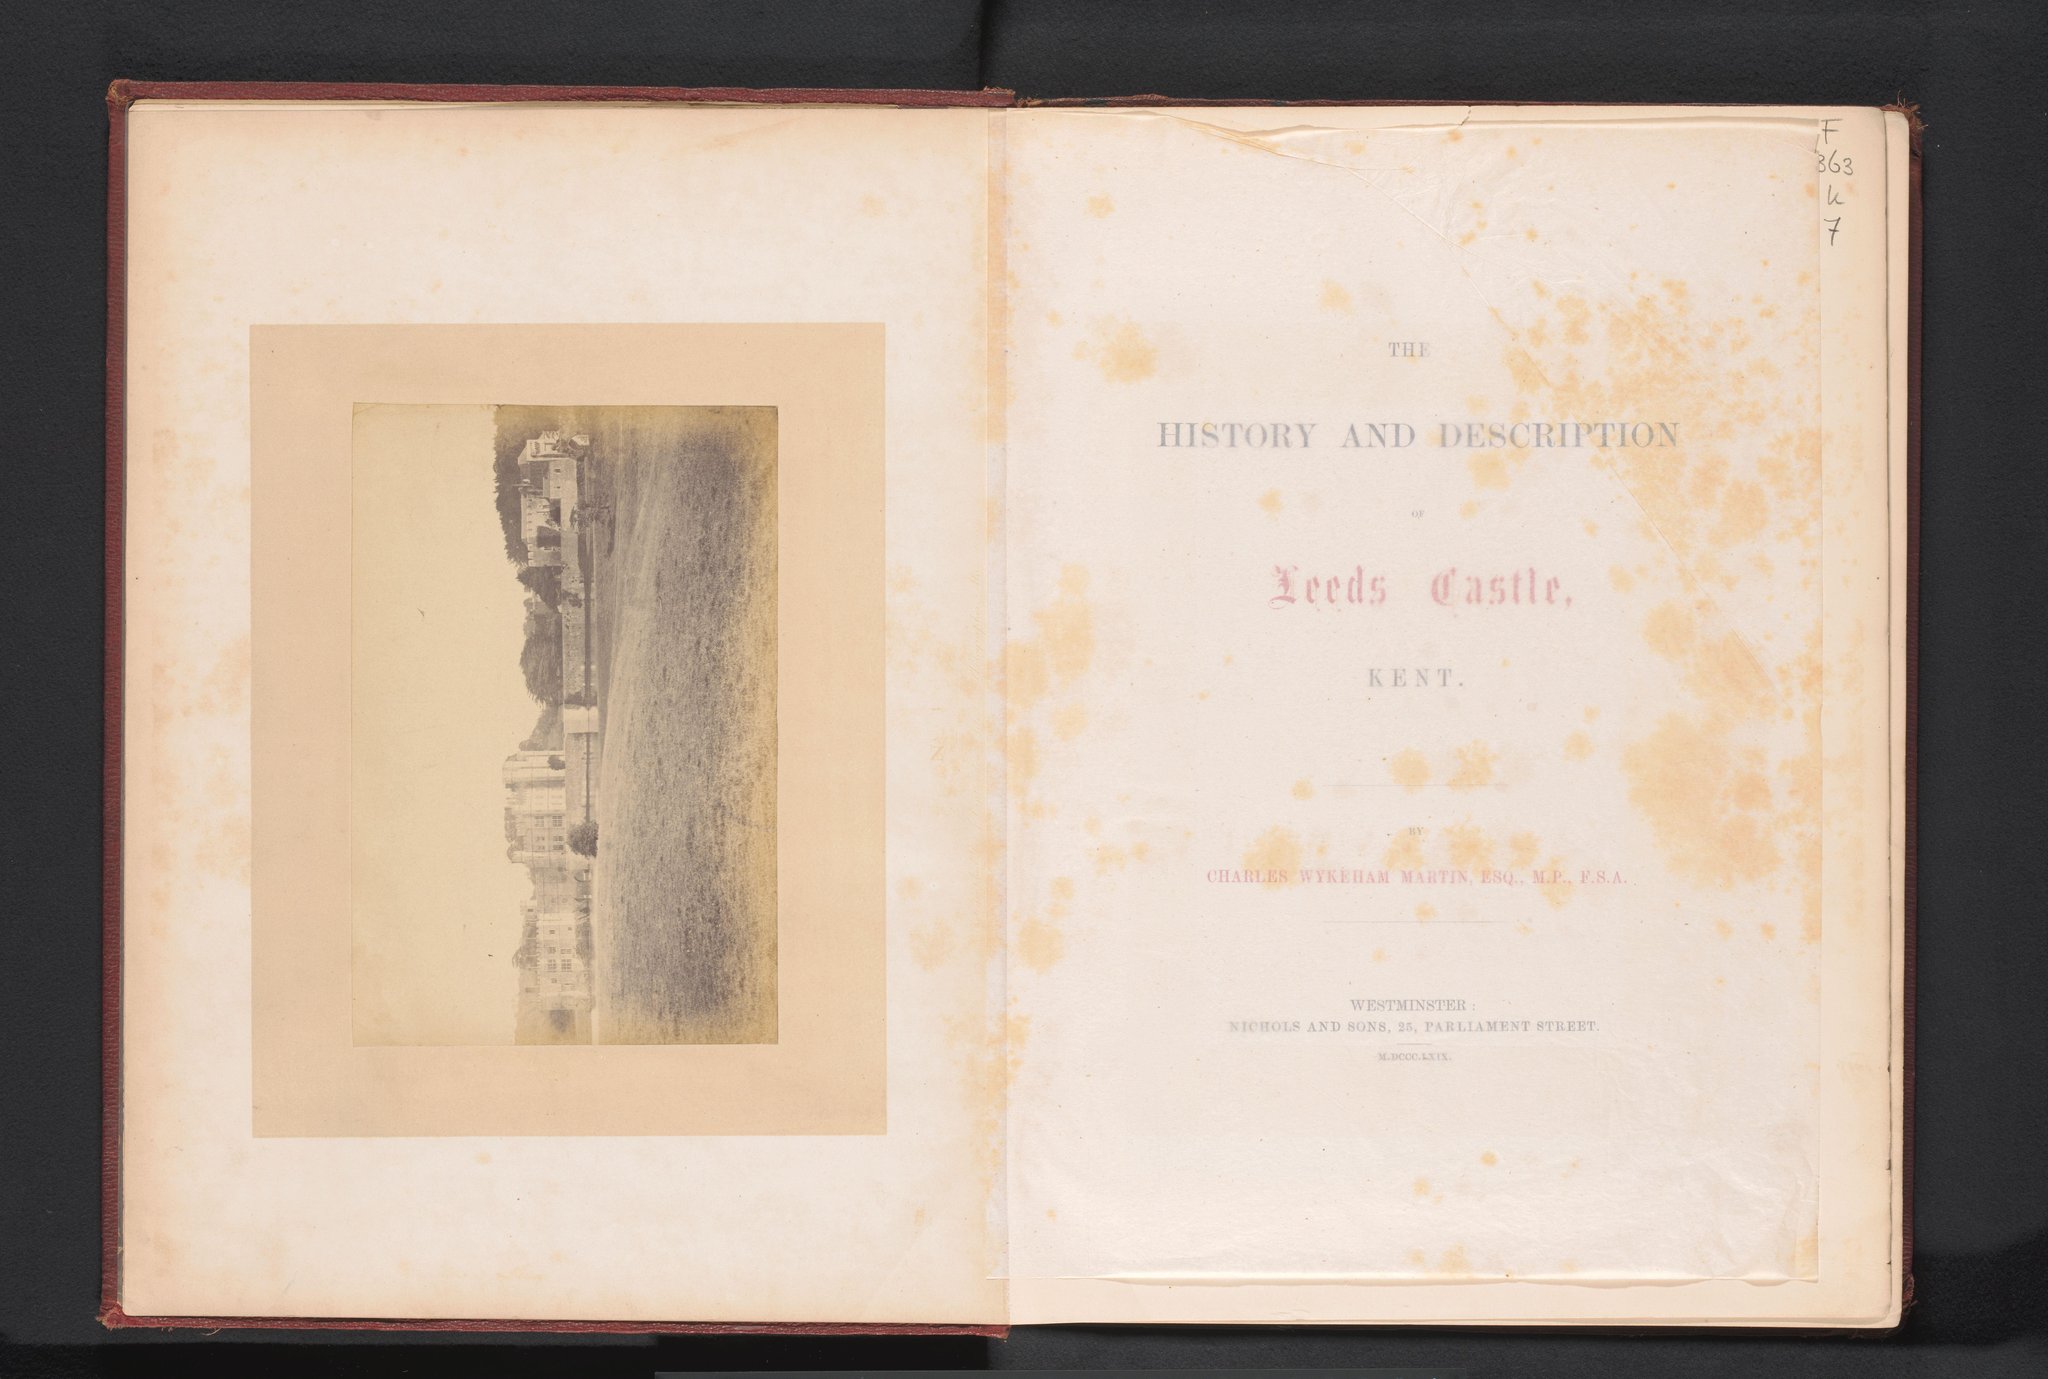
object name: photograph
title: Westzijde van Leeds Castle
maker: john cruttenden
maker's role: fotograaf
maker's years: 1825-1892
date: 1864-1869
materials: photographic support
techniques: albumen print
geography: leeds castle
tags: castle, landscape with tower or castle